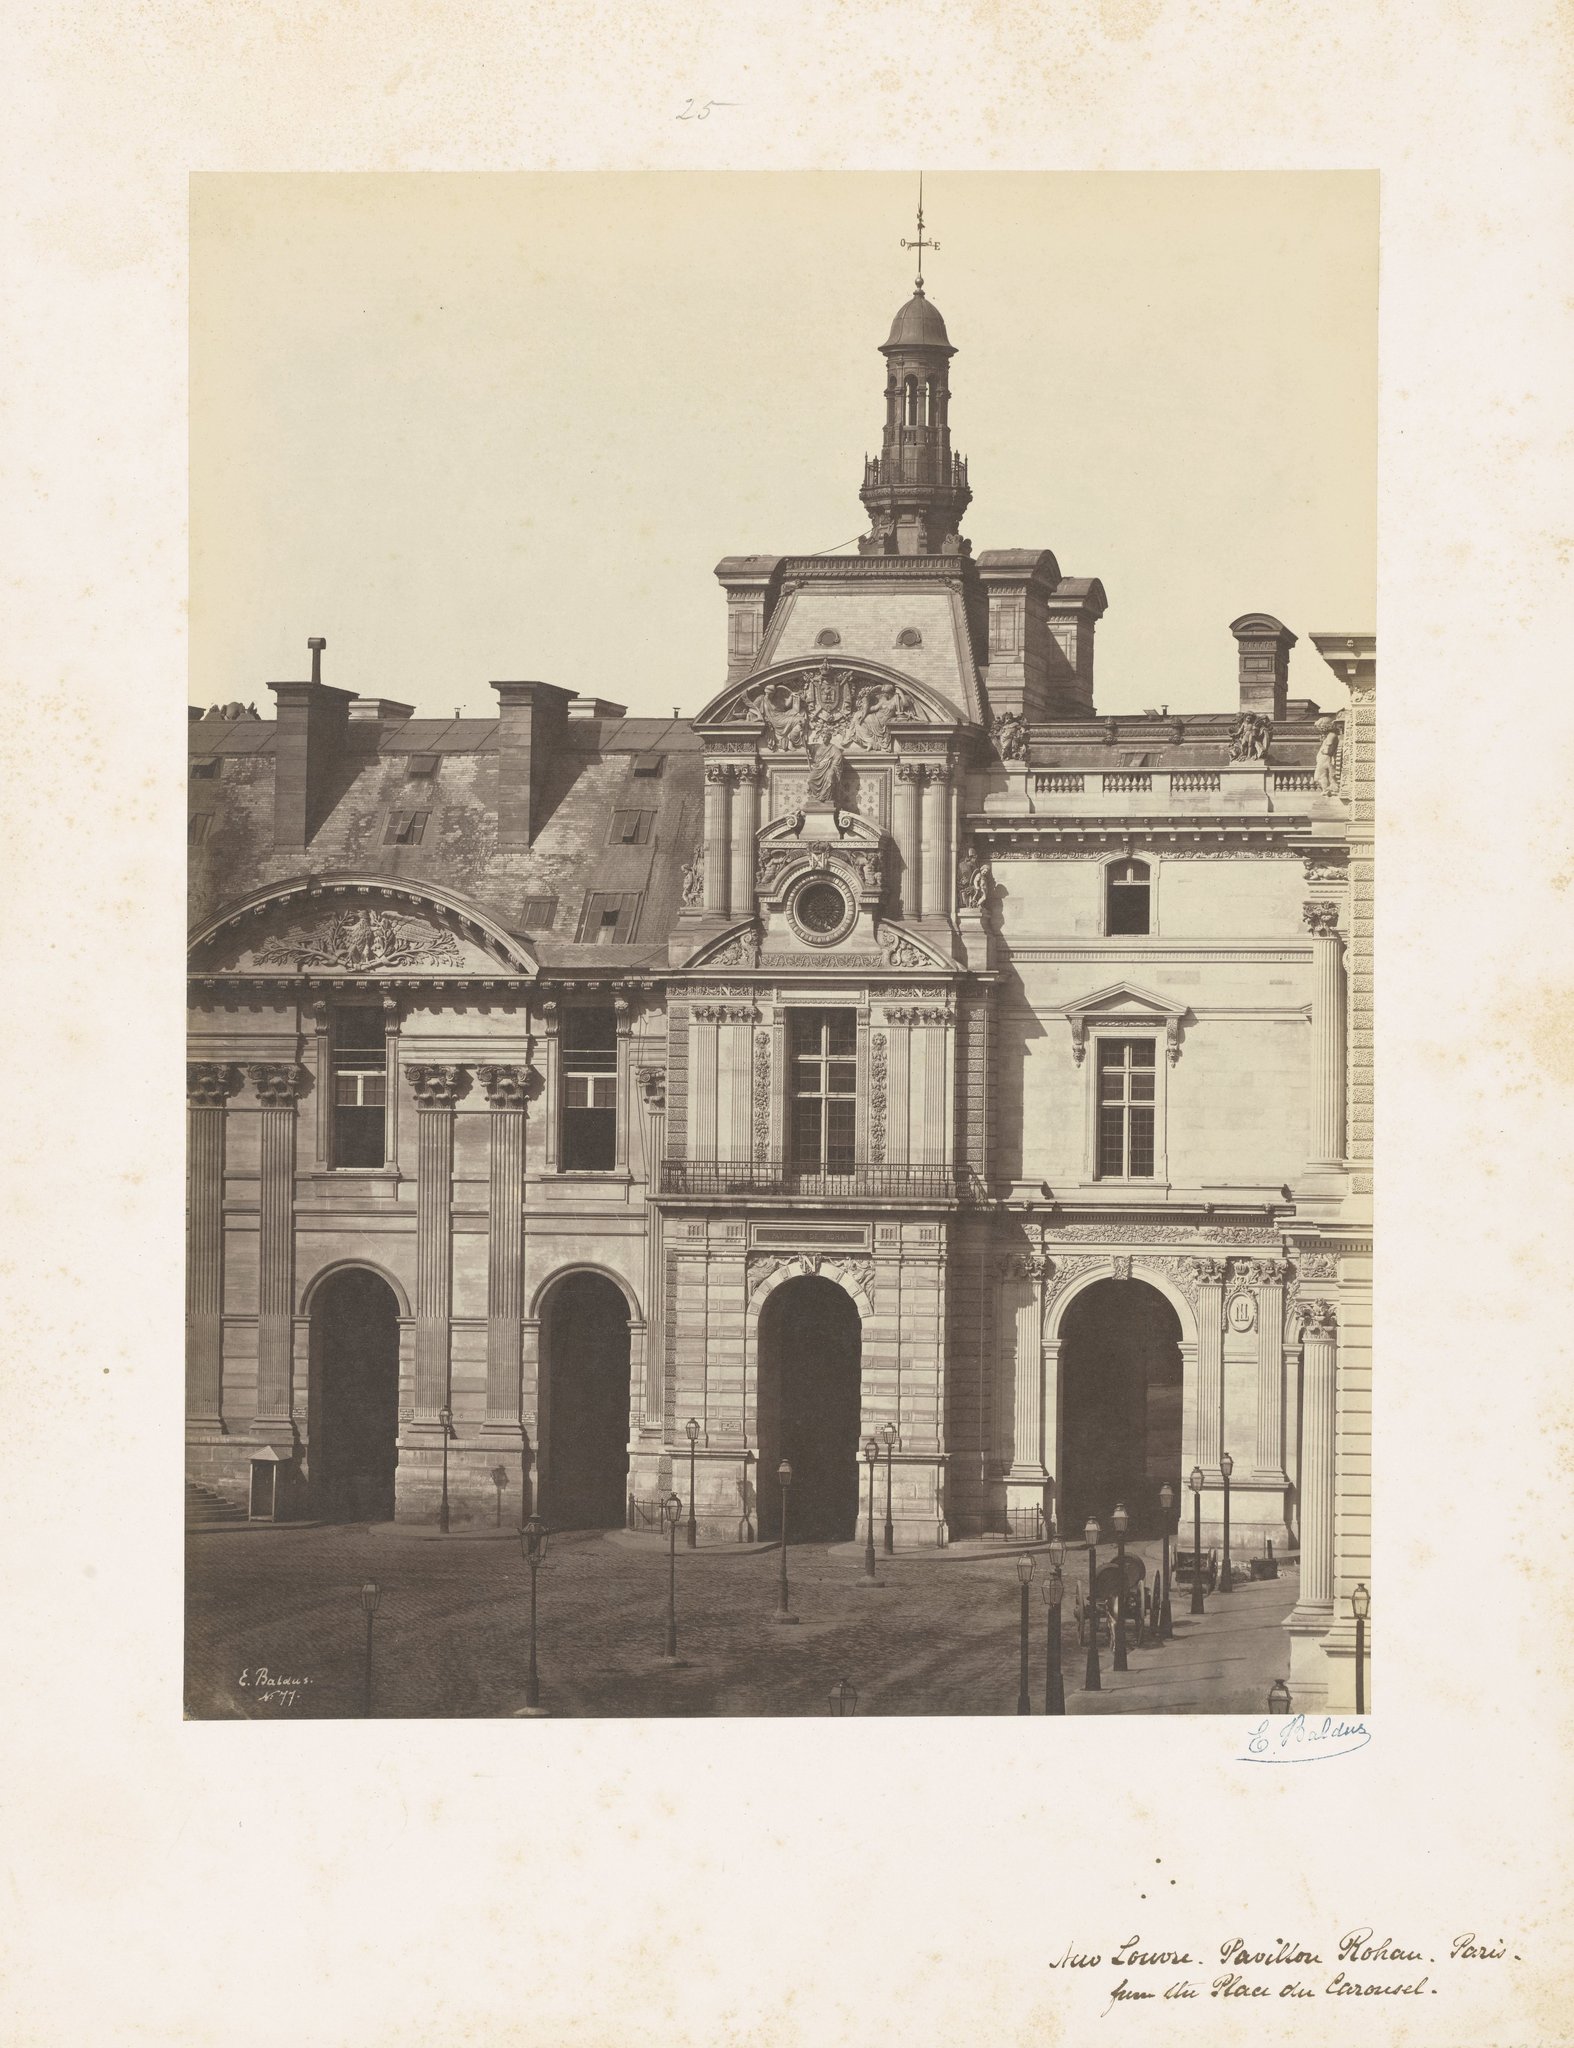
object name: photograph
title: Nouveau Louvre. Pavillon Rohan, Parijs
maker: édouard denis baldus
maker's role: fotograaf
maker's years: 1813-1889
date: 1855-1857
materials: cardboard, photographic support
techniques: salted paper print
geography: france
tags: musée du louvre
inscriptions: inscription: ‘New Louvre. Pavillon Rohan. Paris./ ... Un Place du Carousel’